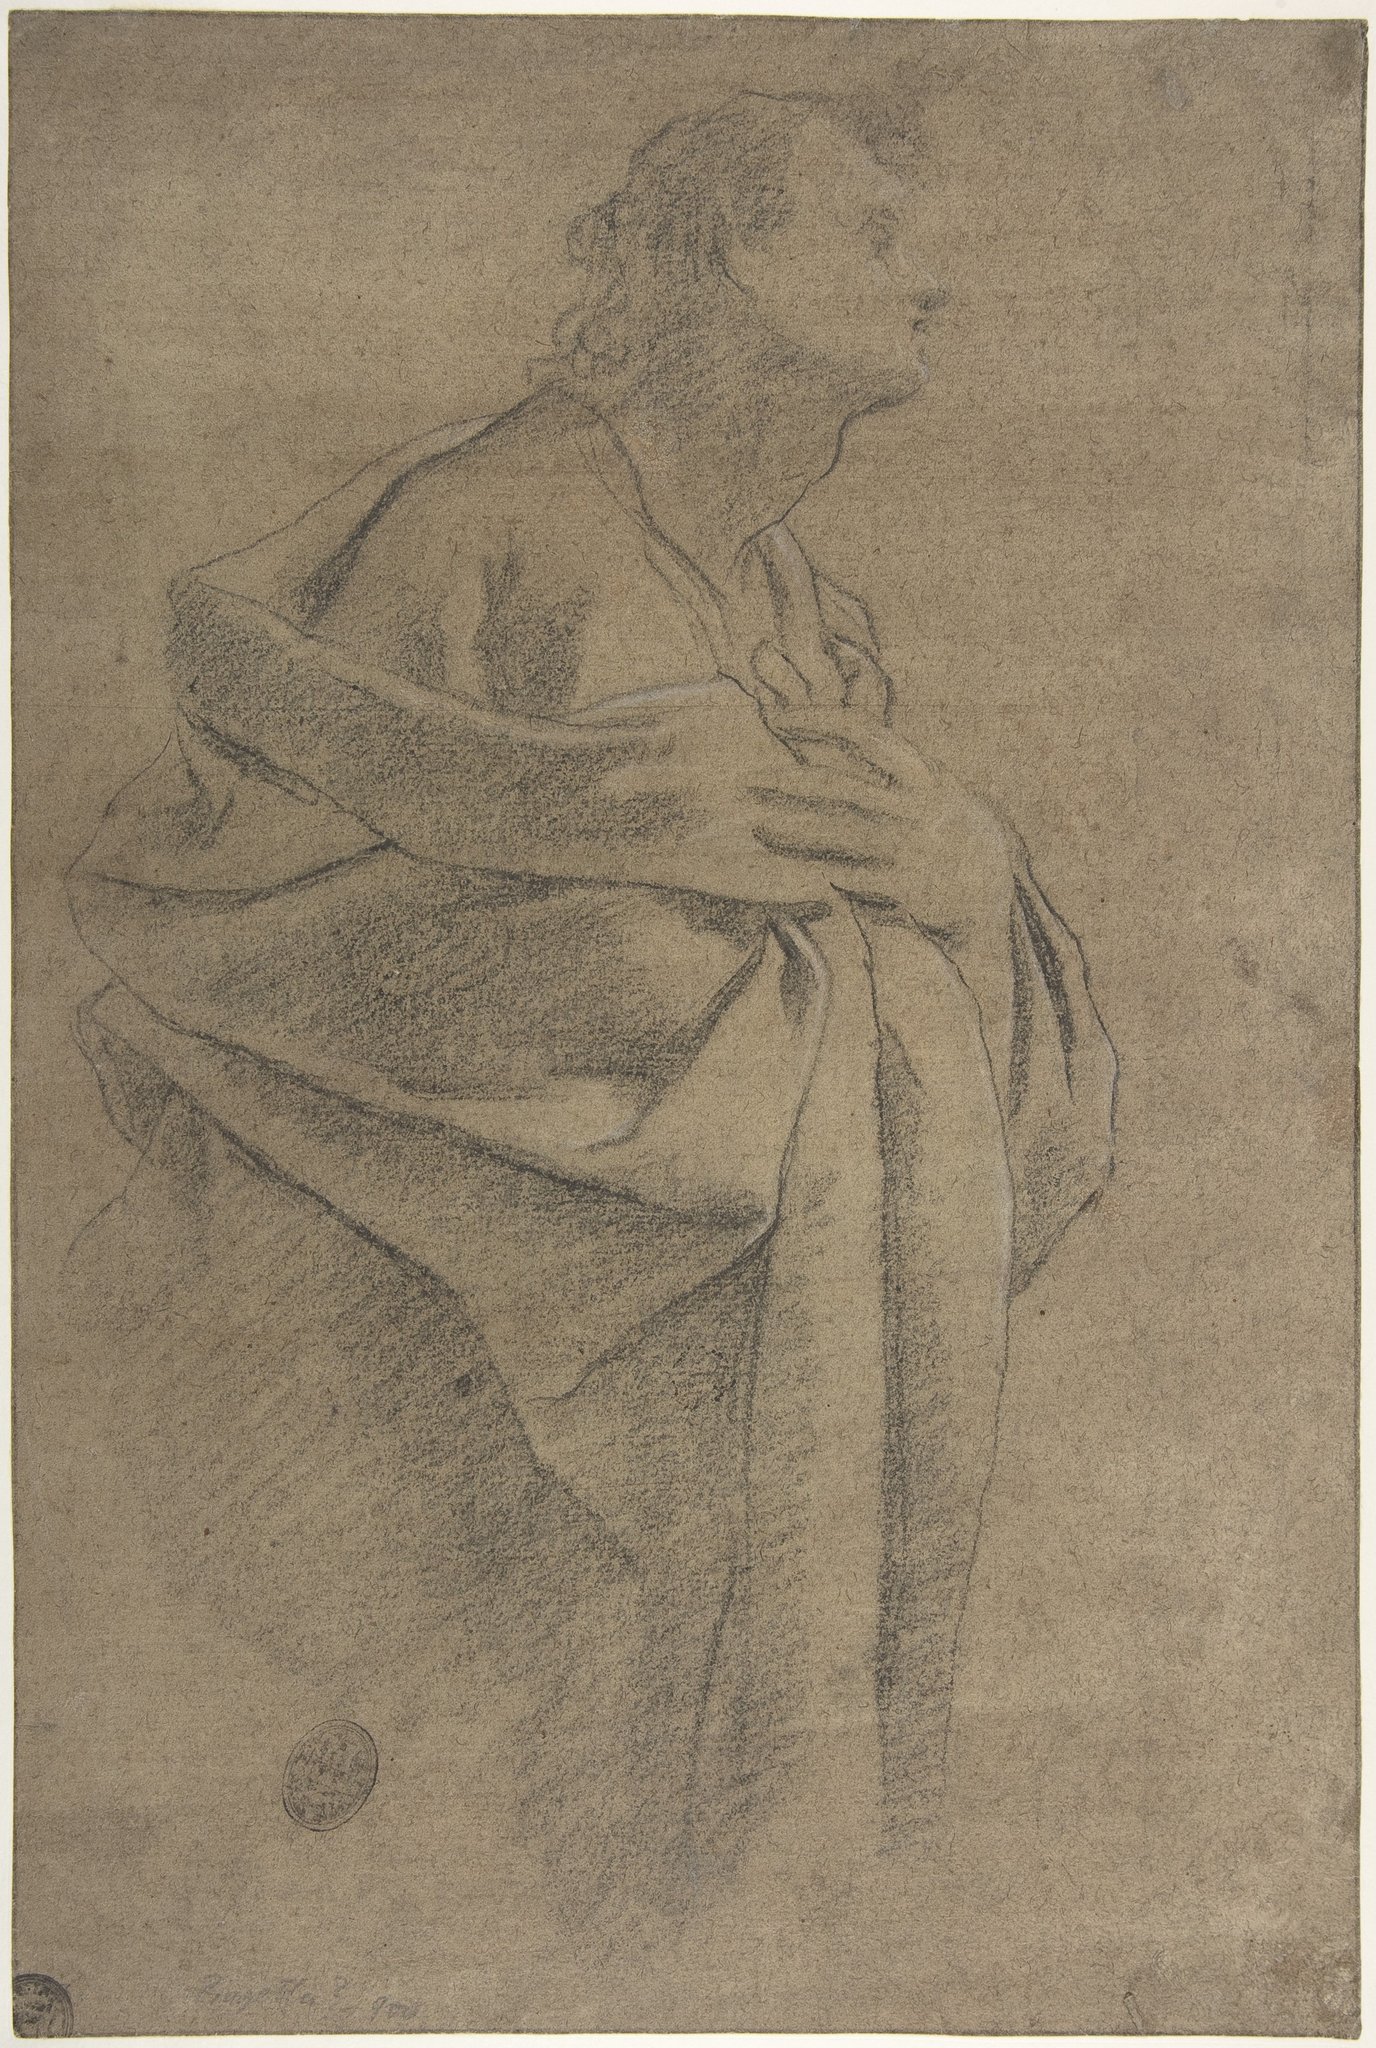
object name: drawing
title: Saint Bartholomew (recto); Study of Drapery and Two Hands (verso)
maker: carlo bononi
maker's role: draughtsman, painter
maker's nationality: italian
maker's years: 1569-1632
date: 1569-1632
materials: chalk, paper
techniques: highlighting, wash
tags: hands,saints